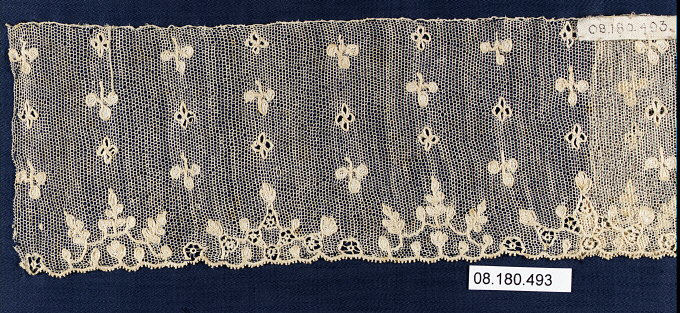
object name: fragment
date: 1701-1800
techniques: lace